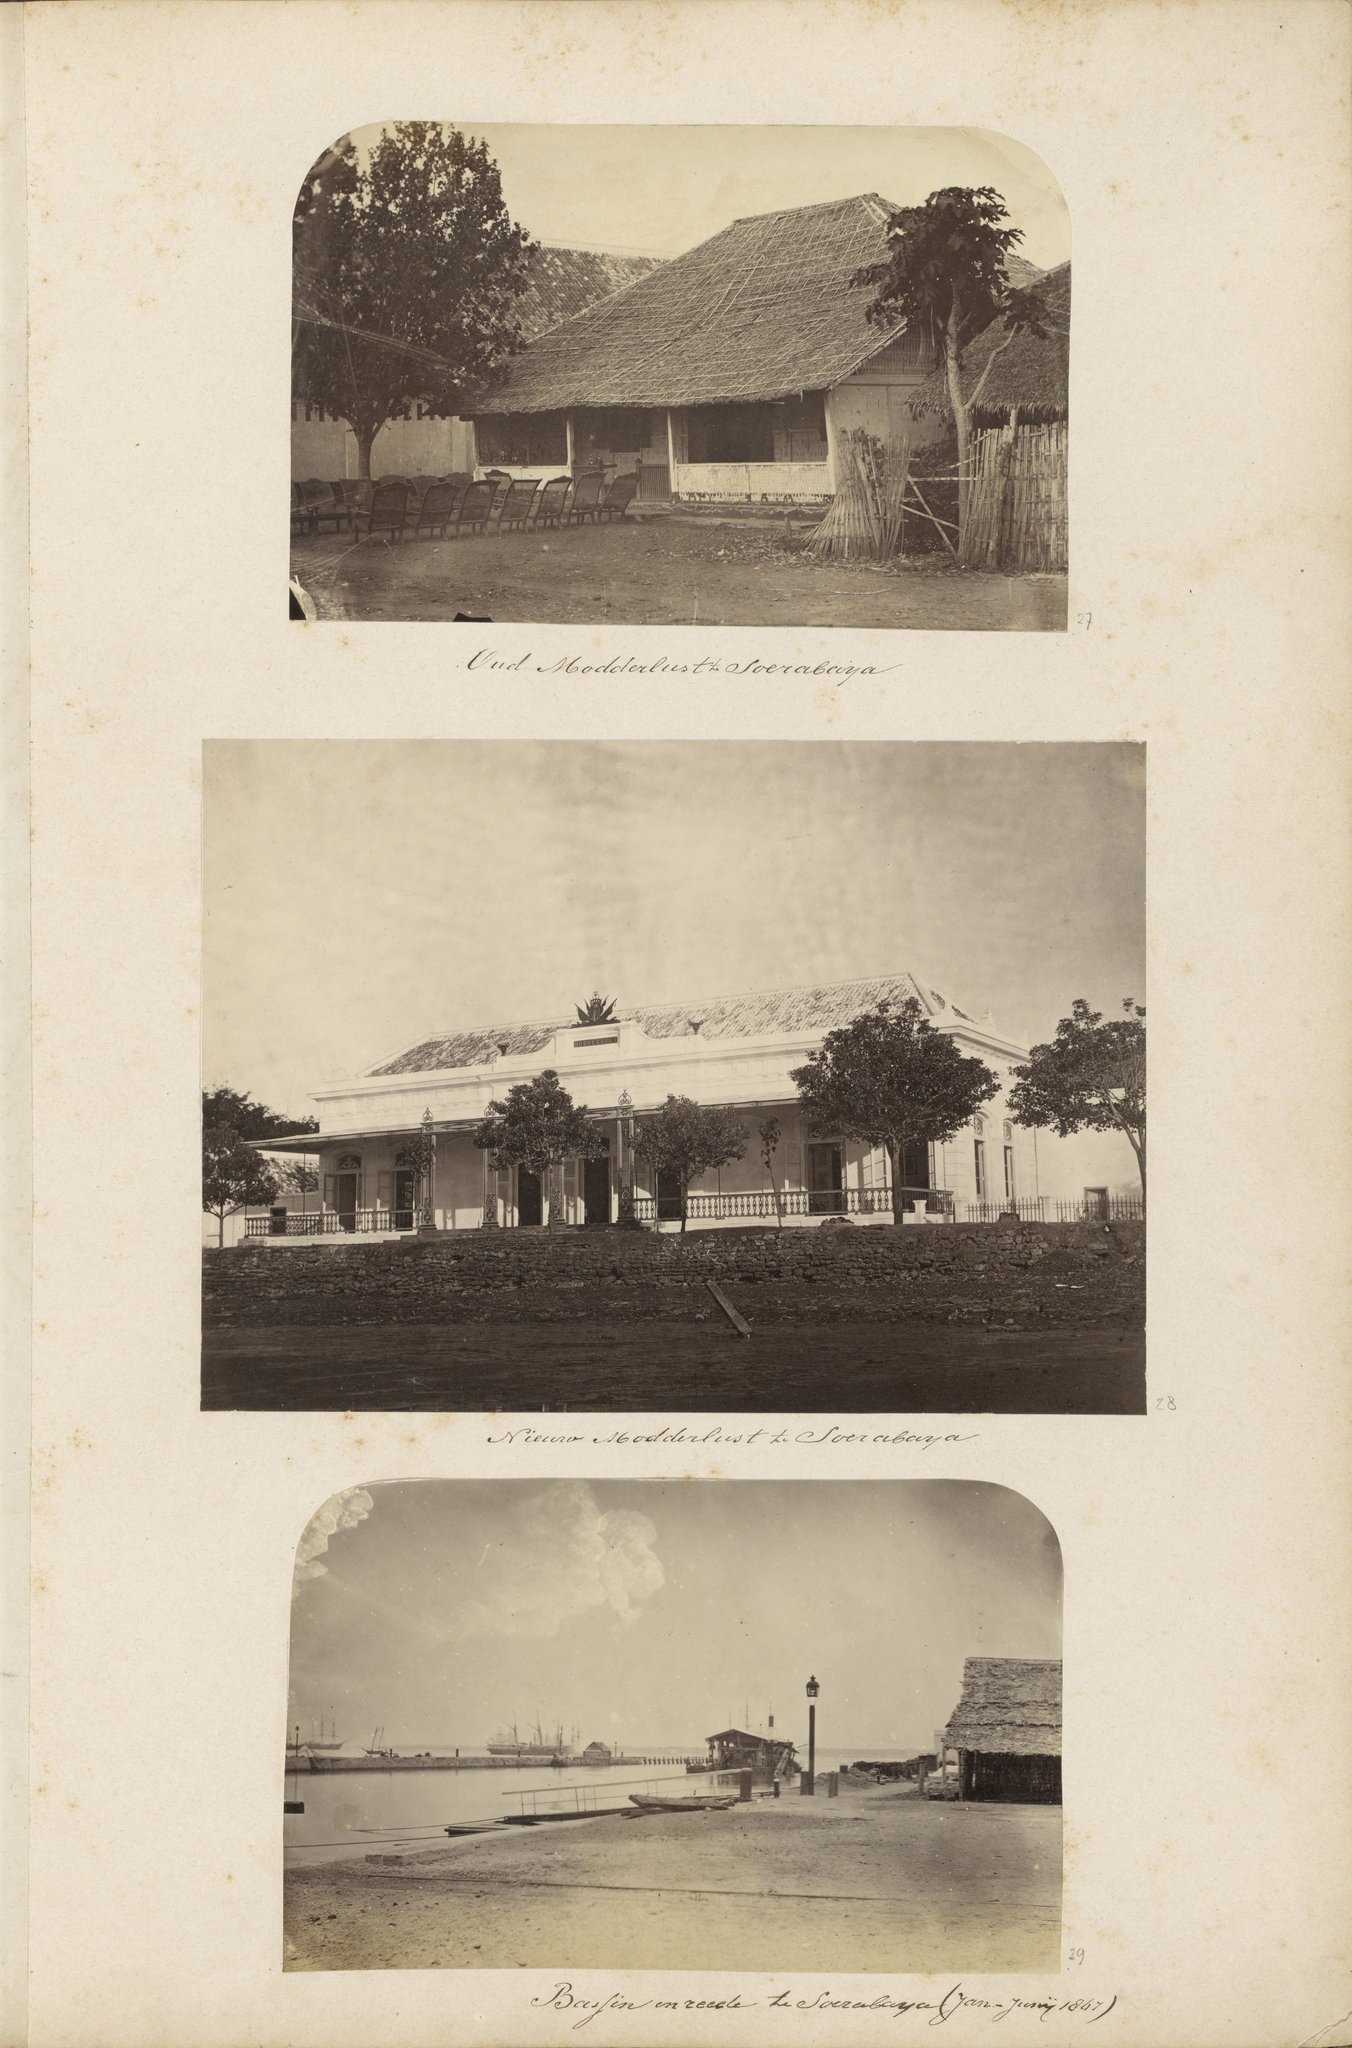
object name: photograph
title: Gezicht op de rede van Soerabaja met op de voorgrond een havenbassin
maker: Anonymous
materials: paper, photographic support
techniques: albumen print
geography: surabaya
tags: harbour (+ view ~ vehicle, ship, etc.), ship in the roads, roadstead, surabaya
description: Onderdeel van Fotoalbum van Robert Daniel Crommelin (1841-1907).